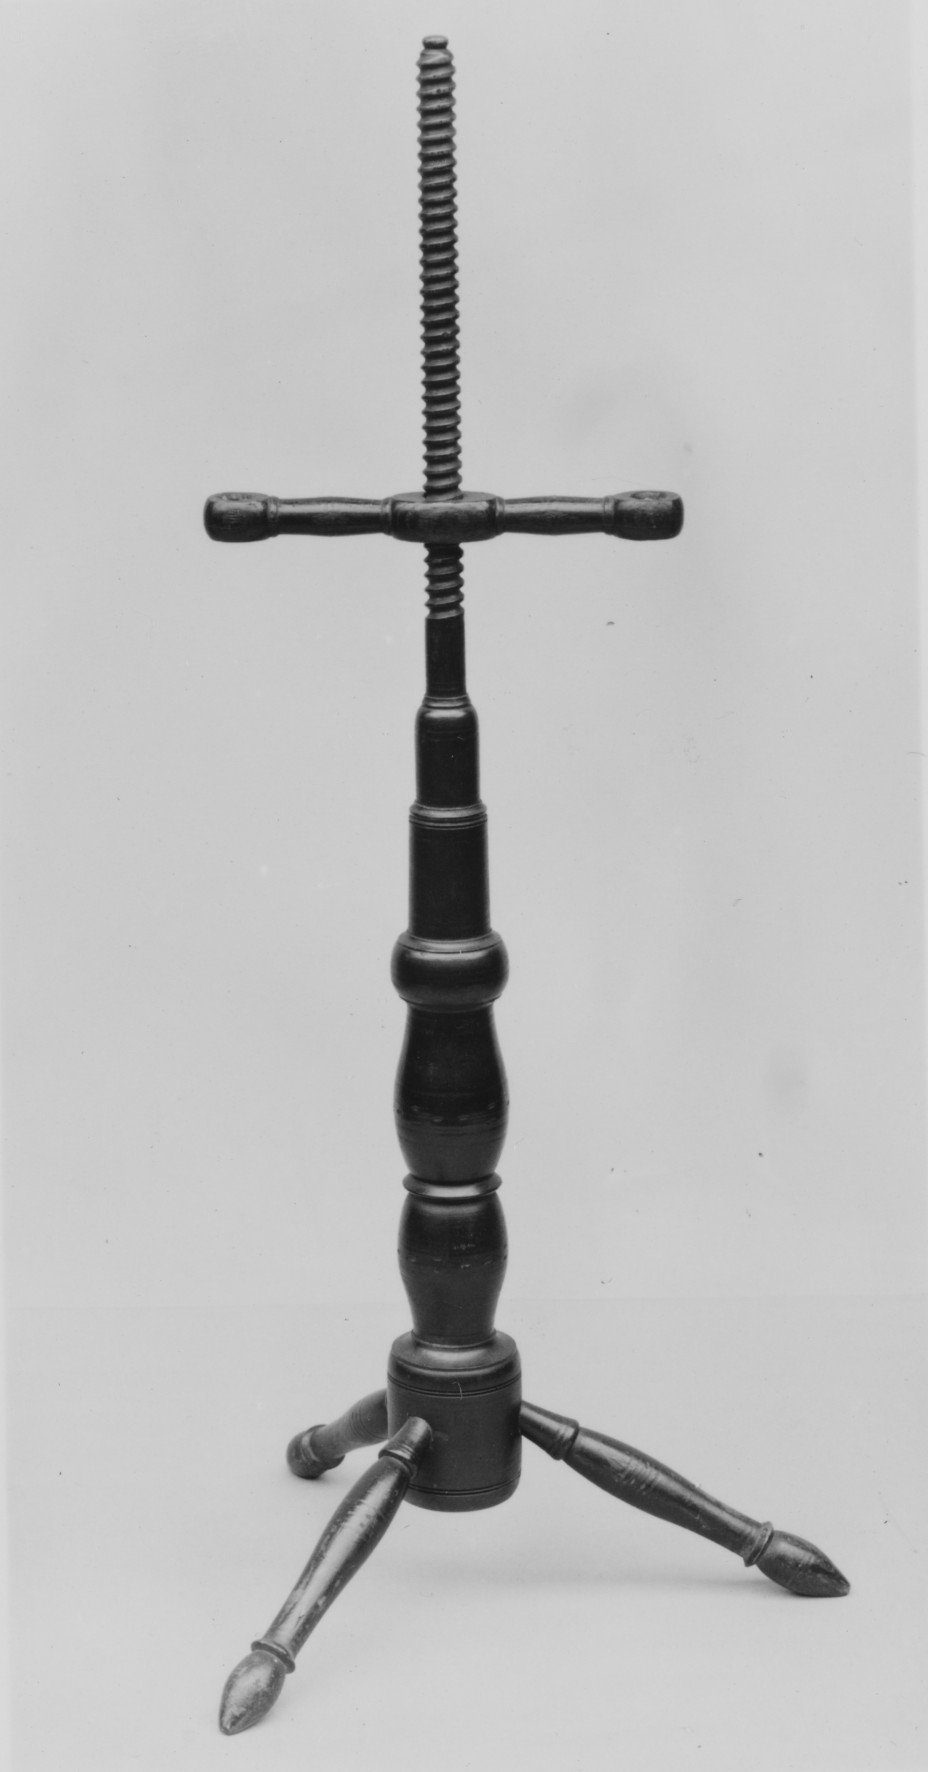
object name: candle stand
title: Candlestand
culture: american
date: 1700-1800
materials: wood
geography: united states